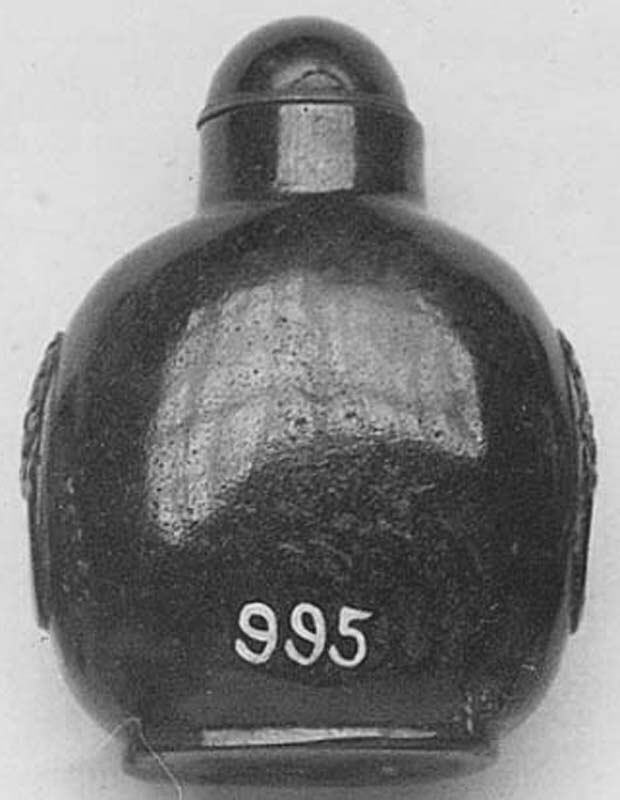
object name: snuff bottle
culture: chinese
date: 1701-1900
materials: jasper